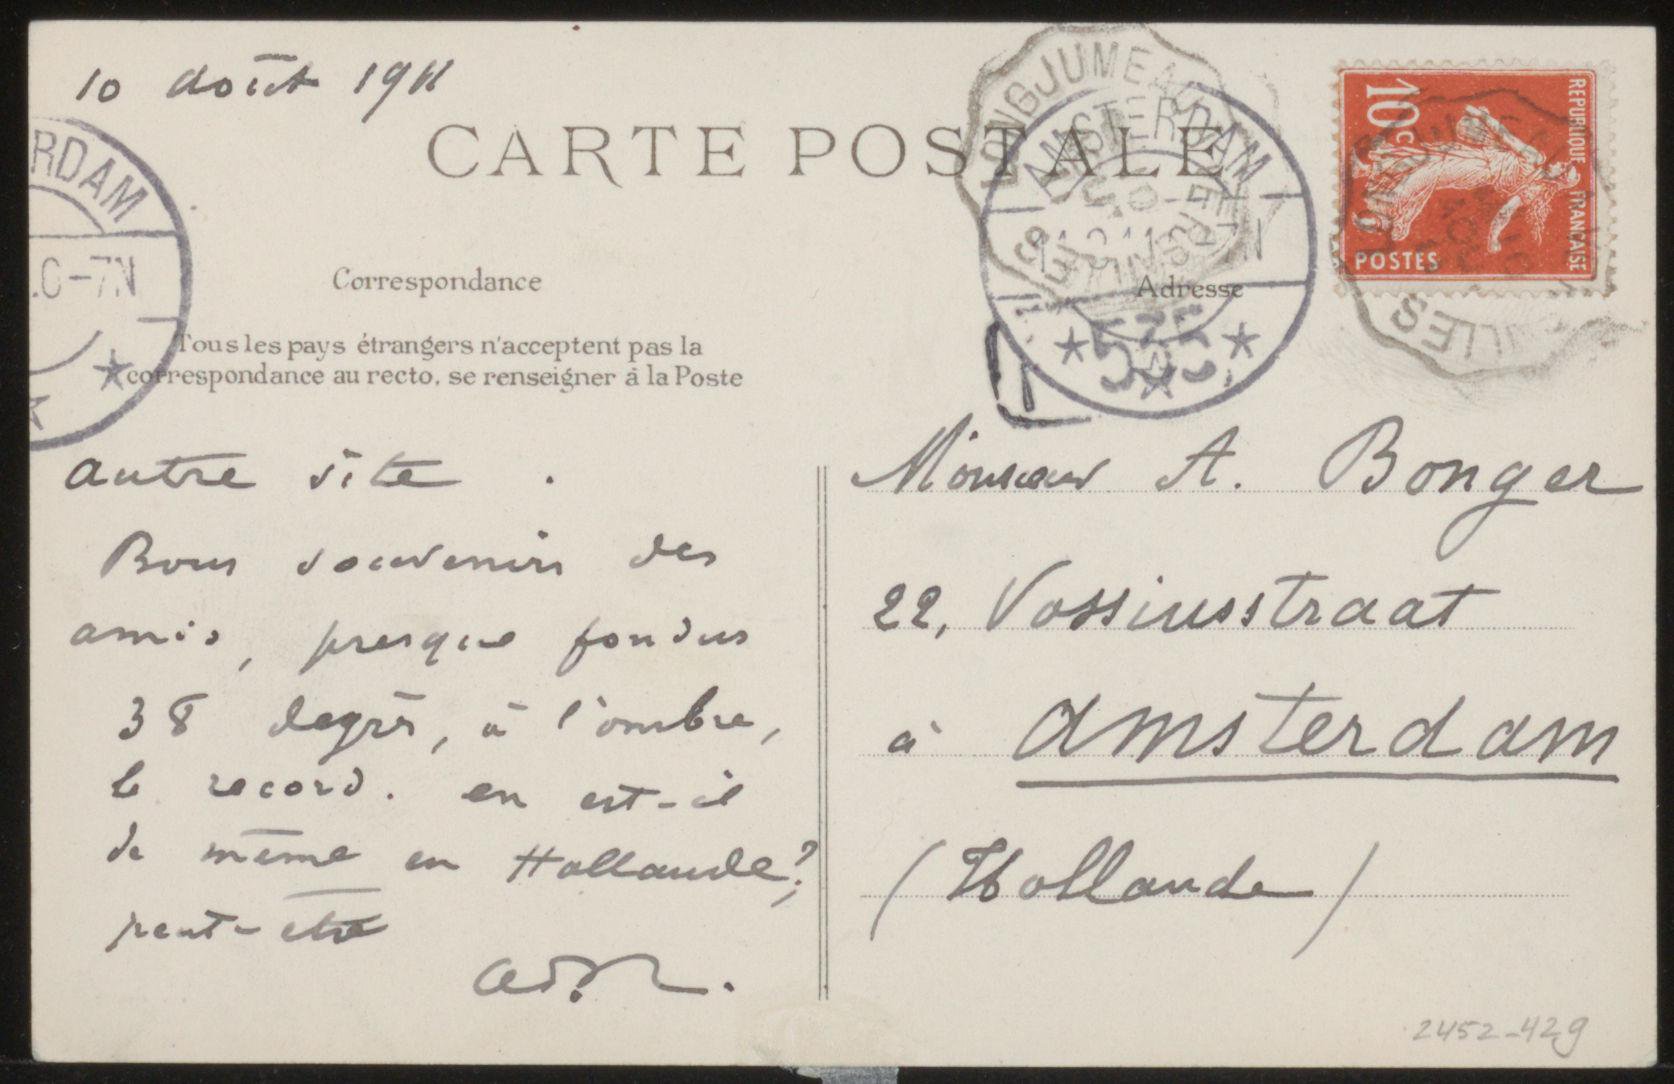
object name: ansichtkaart, prentbriefkaart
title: Prentbriefkaart aan Andries Bonger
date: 1911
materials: cardboard, ink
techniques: photograph, pen, writing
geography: longjumeau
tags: amsterdam, andries bonger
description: Prentbriefkaart behoort tot een album samengesteld door weduwe Françoise W.M. Barones van der Borch van Verwolde met afschriften van brieven met betrekking tot (de familie van) Odilon Redon. De prentbriefkaart werd bewaard op pagina 176.